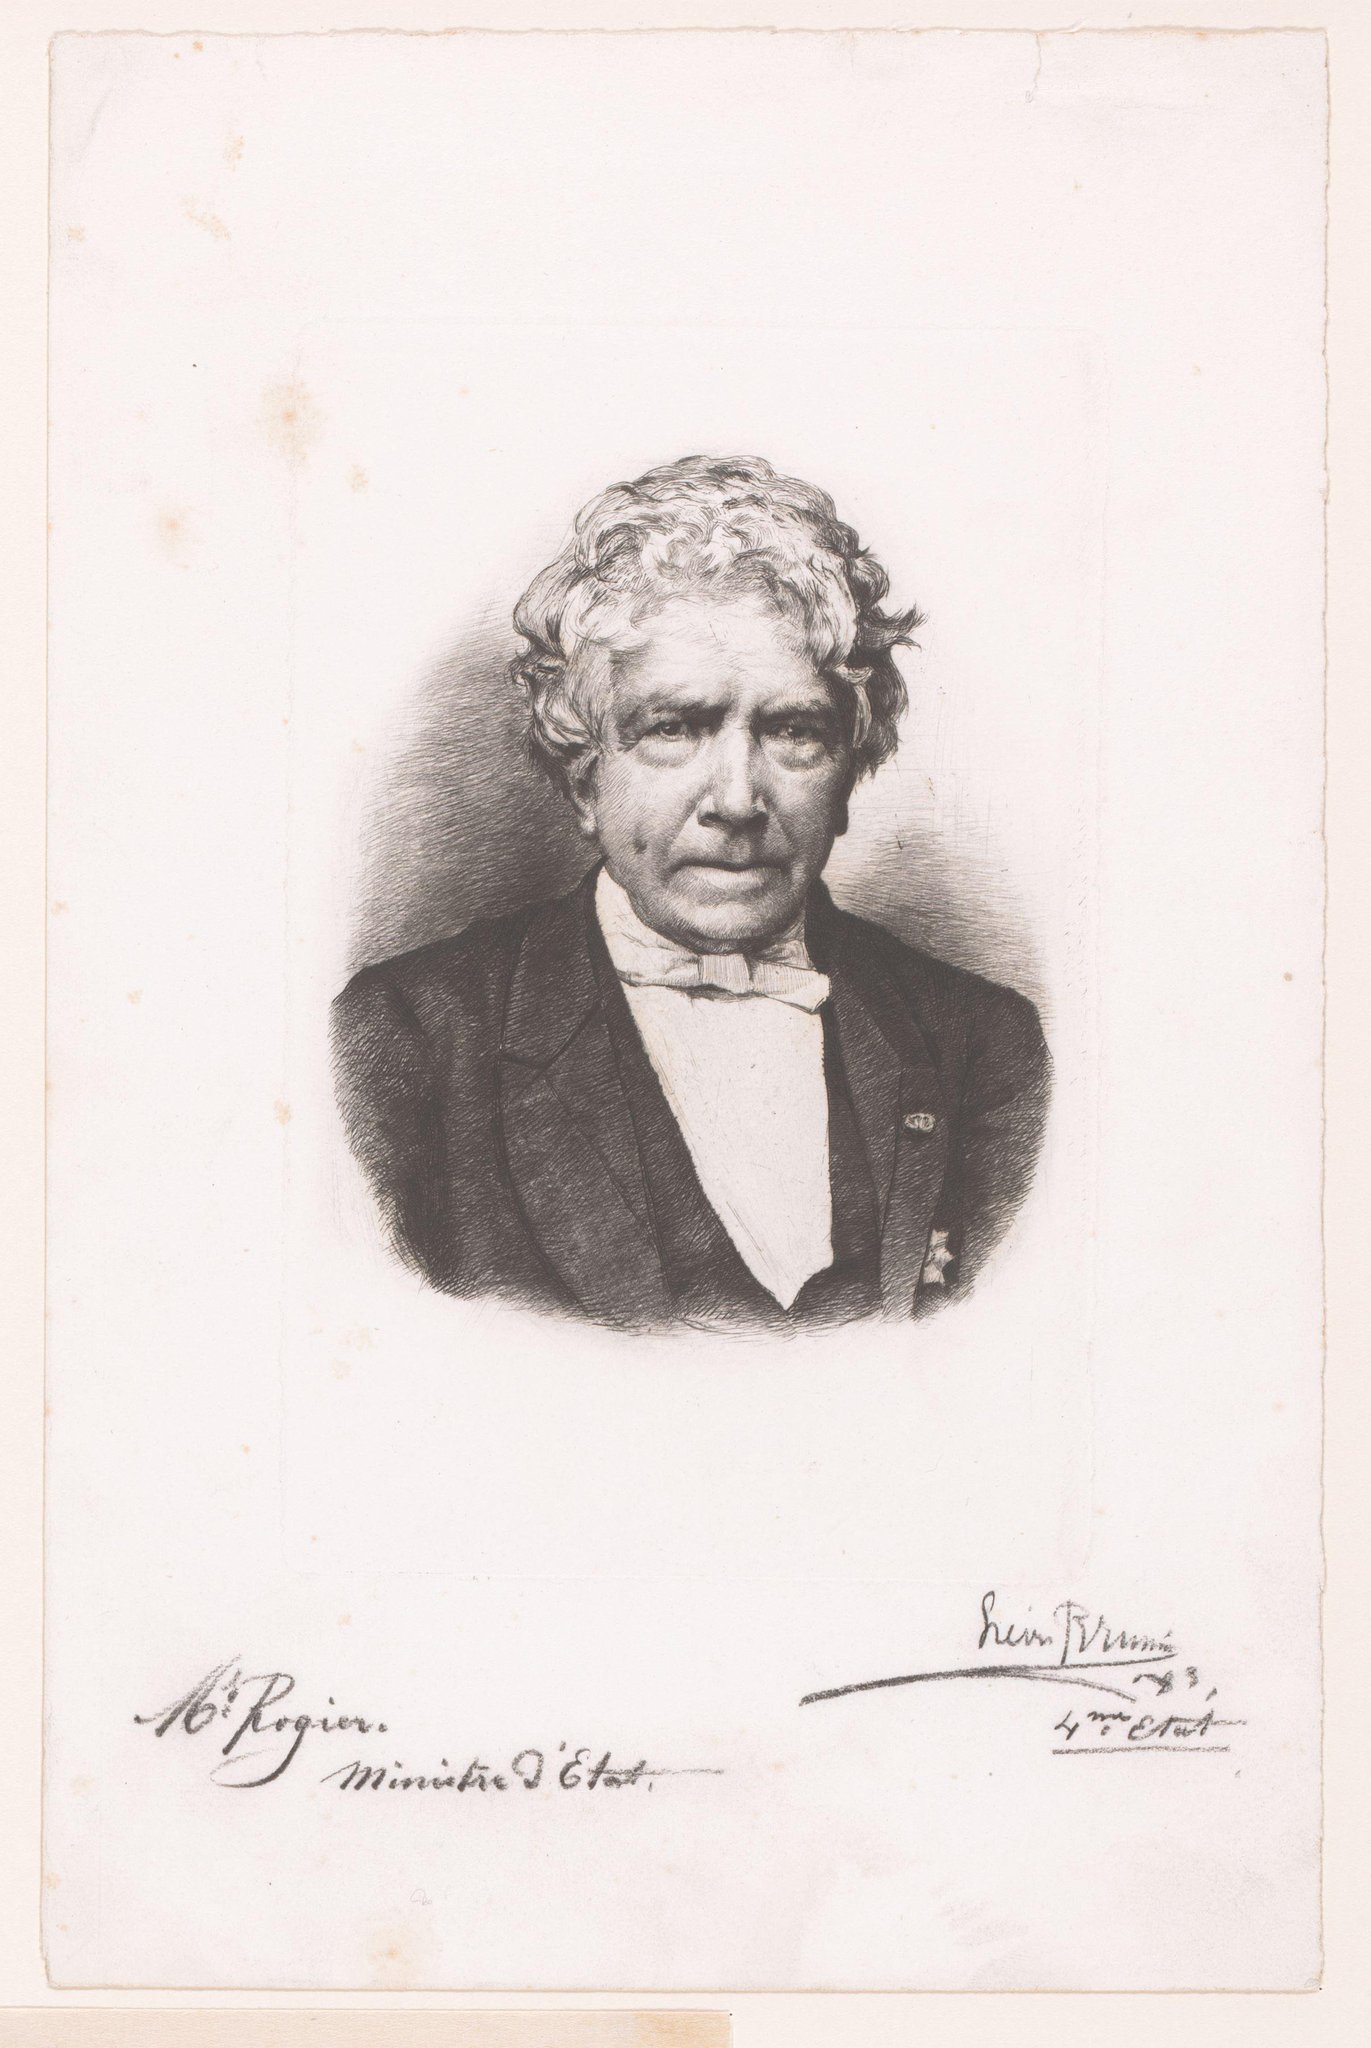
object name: print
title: Portret van Charles Rogier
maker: léon brunin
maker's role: print maker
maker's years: 1861-1949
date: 1883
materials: paper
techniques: etching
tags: politician, politician, e.g. party leader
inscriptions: collector's mark: Lugt 2228, annotation: ‘4me Etat’